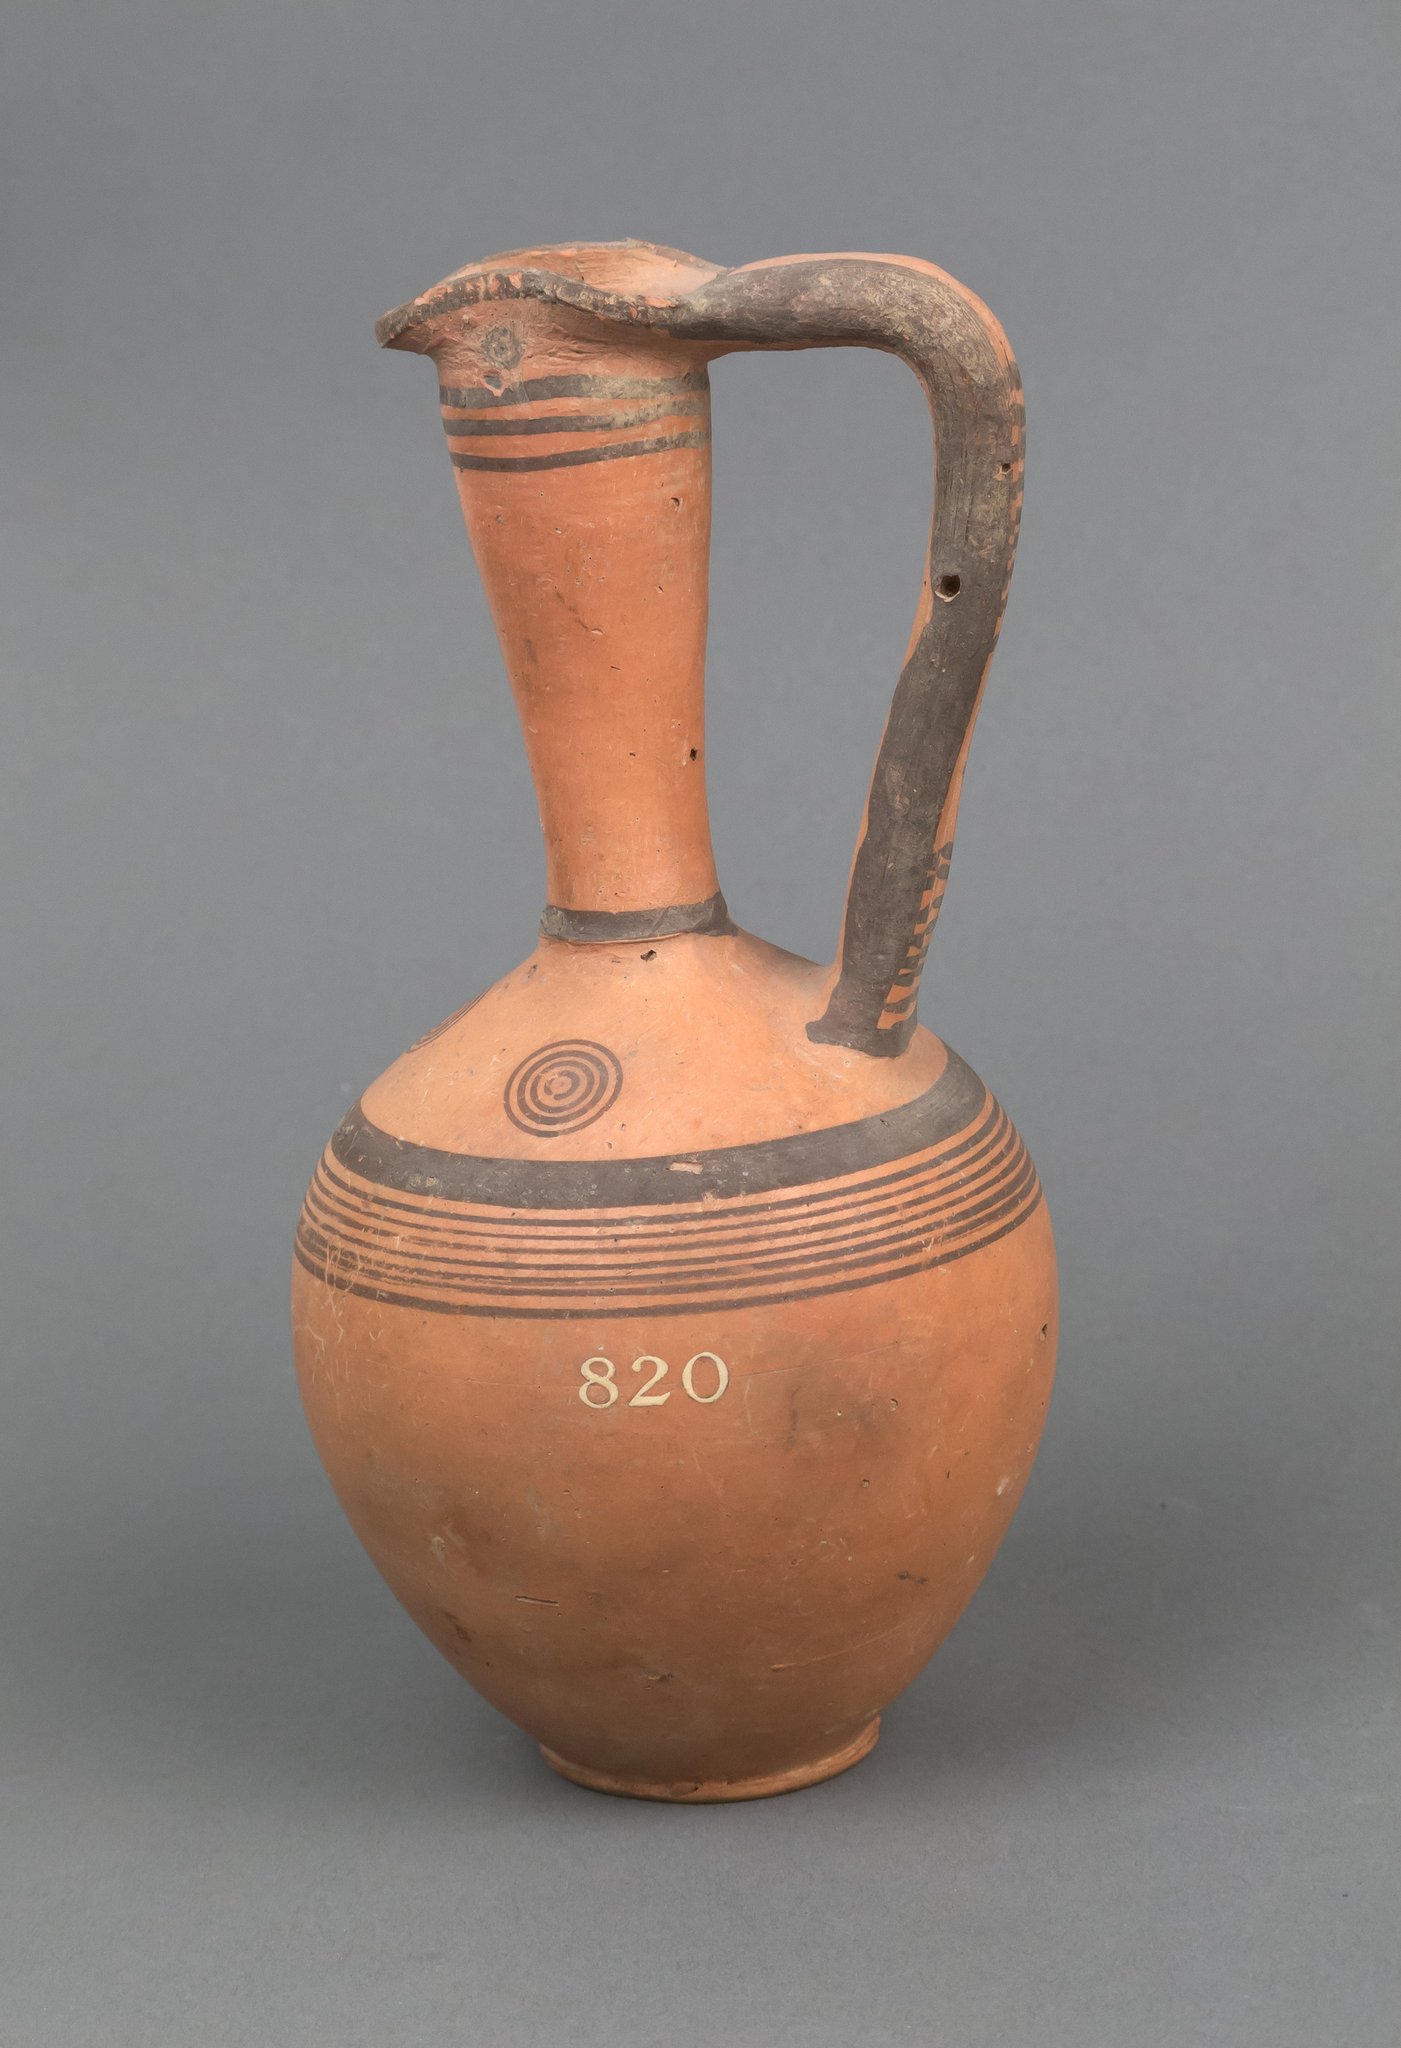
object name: oinochoe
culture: cypriot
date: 850-750 BCE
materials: terracotta